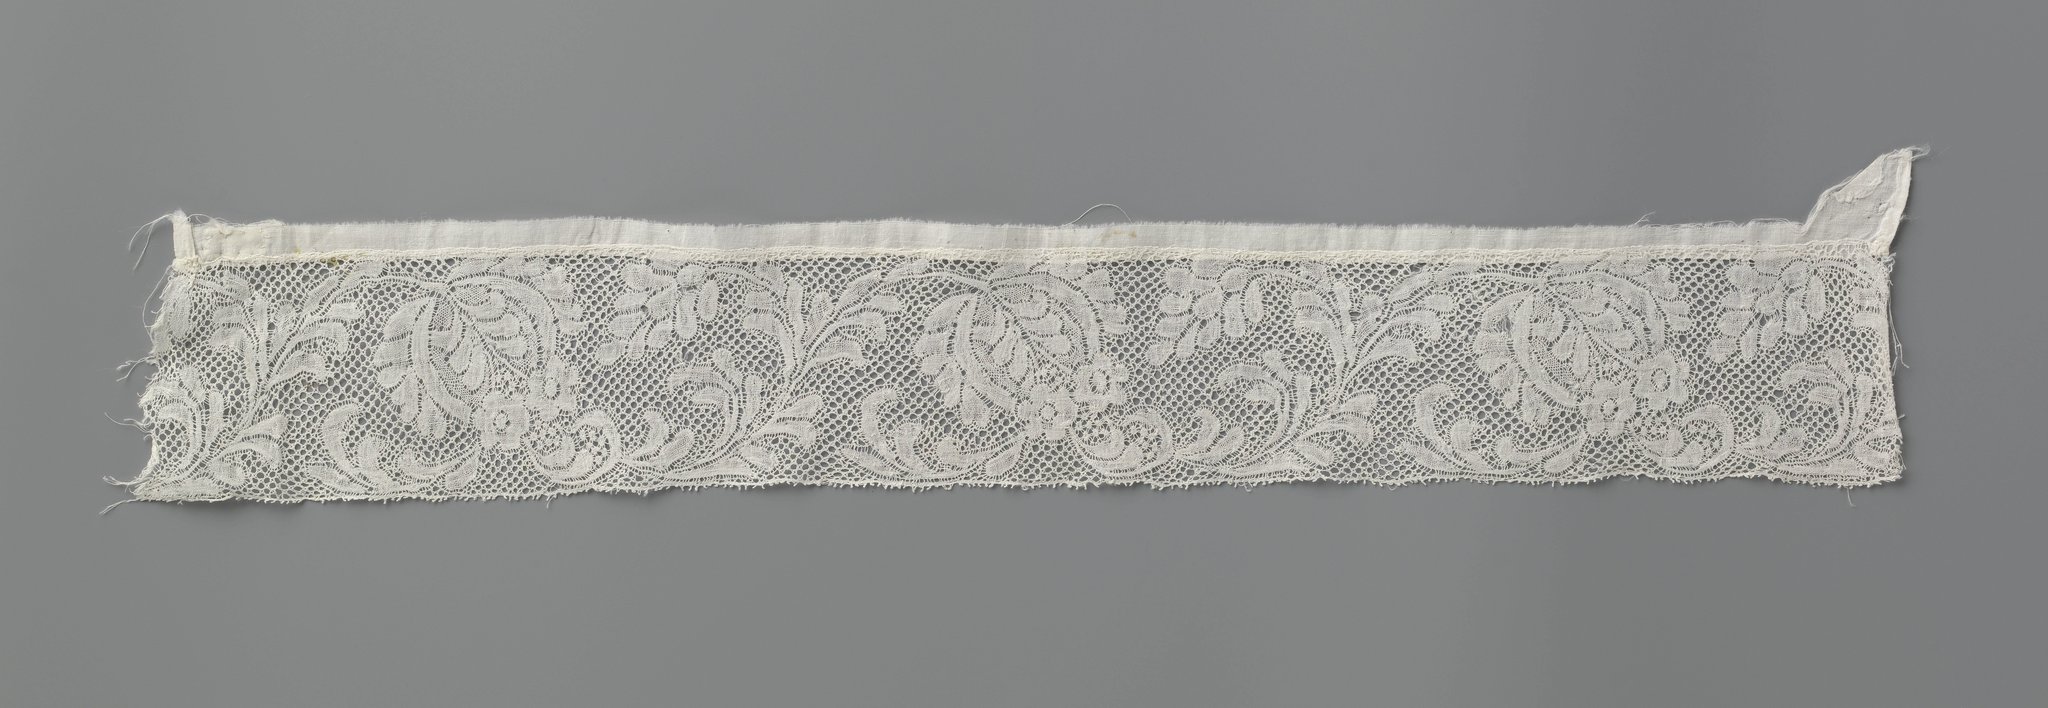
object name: strip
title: Strook kloskant met gespleten tak en tulp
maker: Anonymous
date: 1750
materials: linen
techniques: lace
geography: southern netherlands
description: Strook naturelkleurige kloskant: Binche-kant. Op een traliegrond, een vijfgaatjesgrond, staat een met gevederde bladeren bezette spiraaltak. Een grote tulp, waarin een gespleten tak met twee bloempjes en een kleine druiventros wisselen elkaar af. De motieven zijn gemaakt in linnenslag en netslag met opengewerkte randjes. Als siergrond is spaarzaam een sneeuwvlokkengrond toegepast. De bovenzijde van de strook is recht afgewerkt en aan een smalle baan afgeknipt batist bevestigt. De rechte onderzijde van de strook kant is afgewerkt met picots.